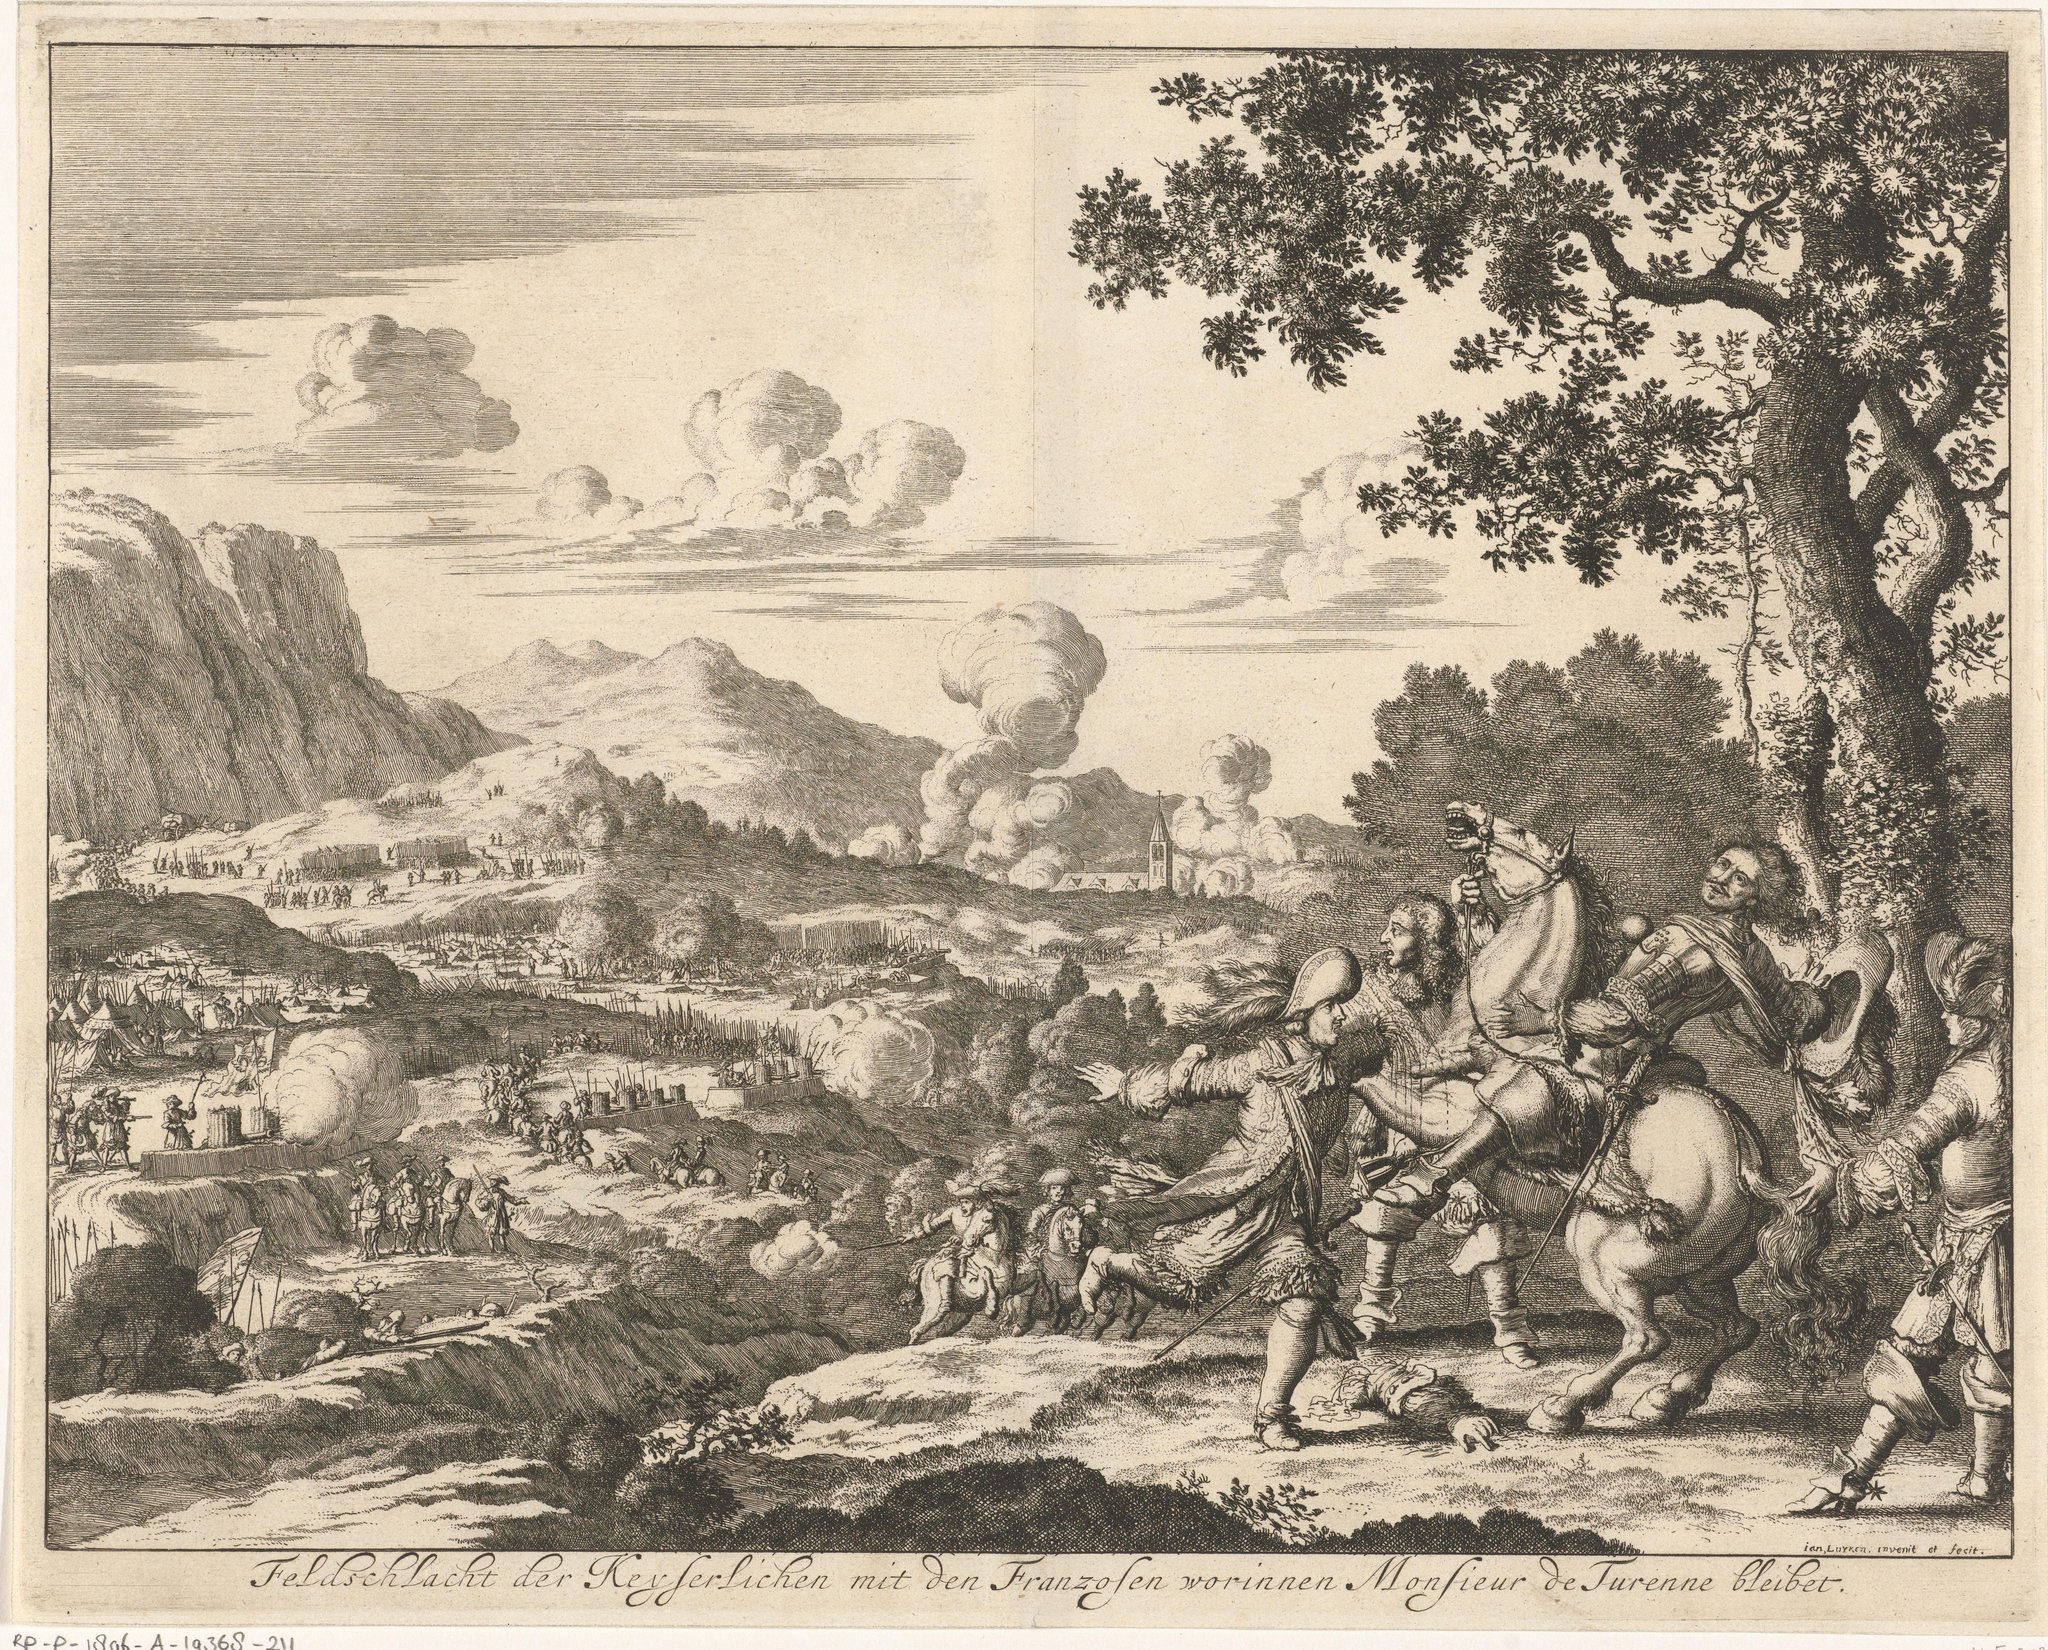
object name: print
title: Slag bij Sasbach, 1674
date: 1680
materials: paper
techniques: etching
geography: amsterdam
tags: violent death, being killed; being mishandled and maltreated; seeking death, battle (+ land forces)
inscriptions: collector's mark: Lugt 2228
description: Veldslag bij Sasbach (of Salzbach of Rosentach) tussen het keizerlijke leger en het Franse leger, 27 juli 1675. Bij de slag komt maarschalk Turenne om het leven. Turenne wordt zittend op zijn paard door een kogel getroffen.